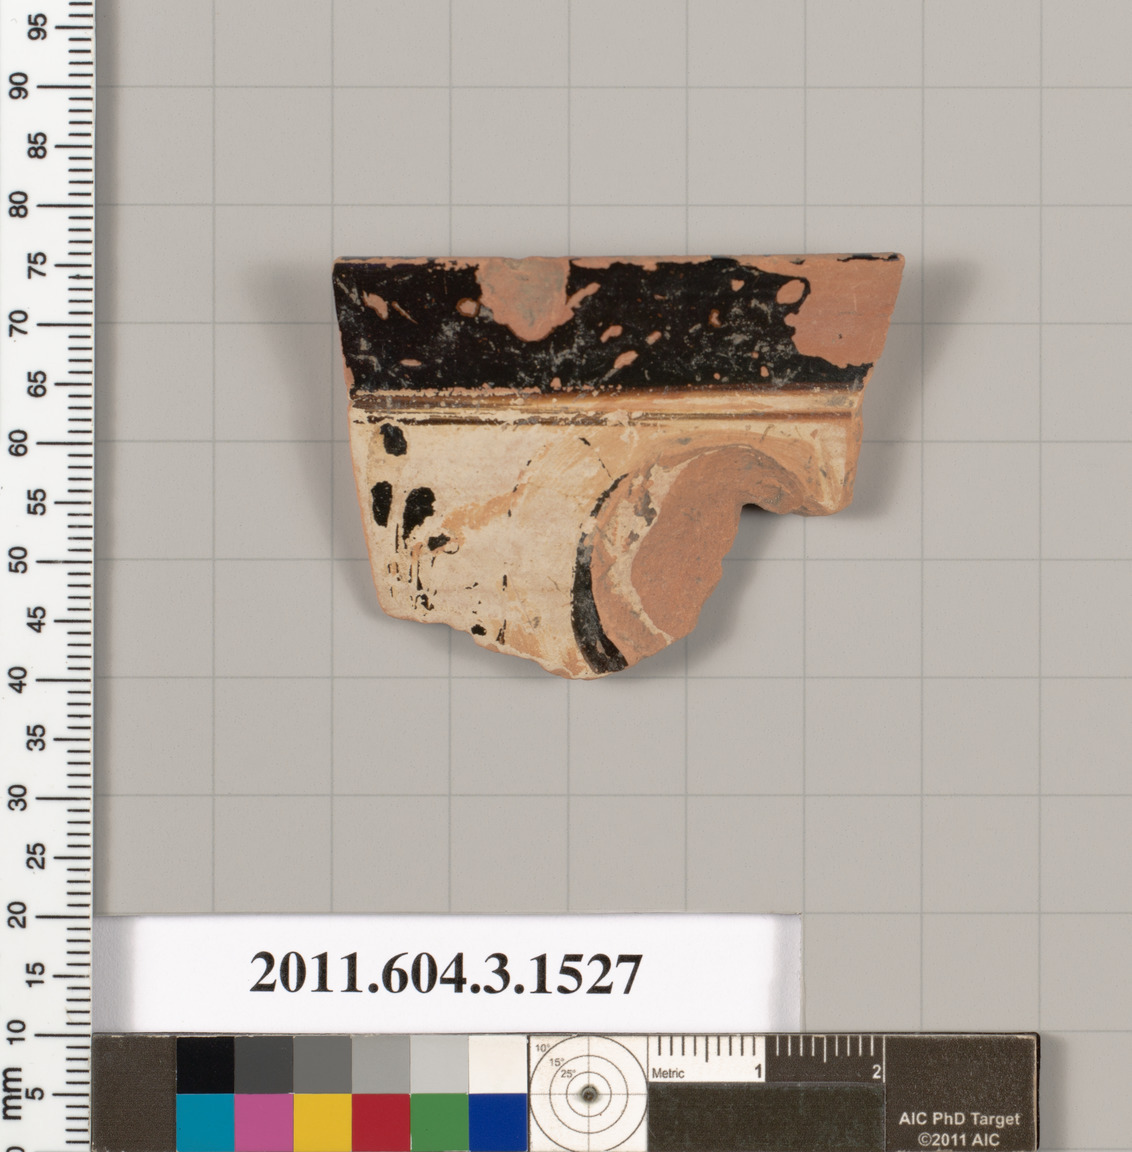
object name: skyphos fragment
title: Terracotta rim fragment of a skyphos (deep drinking cup)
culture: greek, attic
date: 534-468 BCE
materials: terracotta